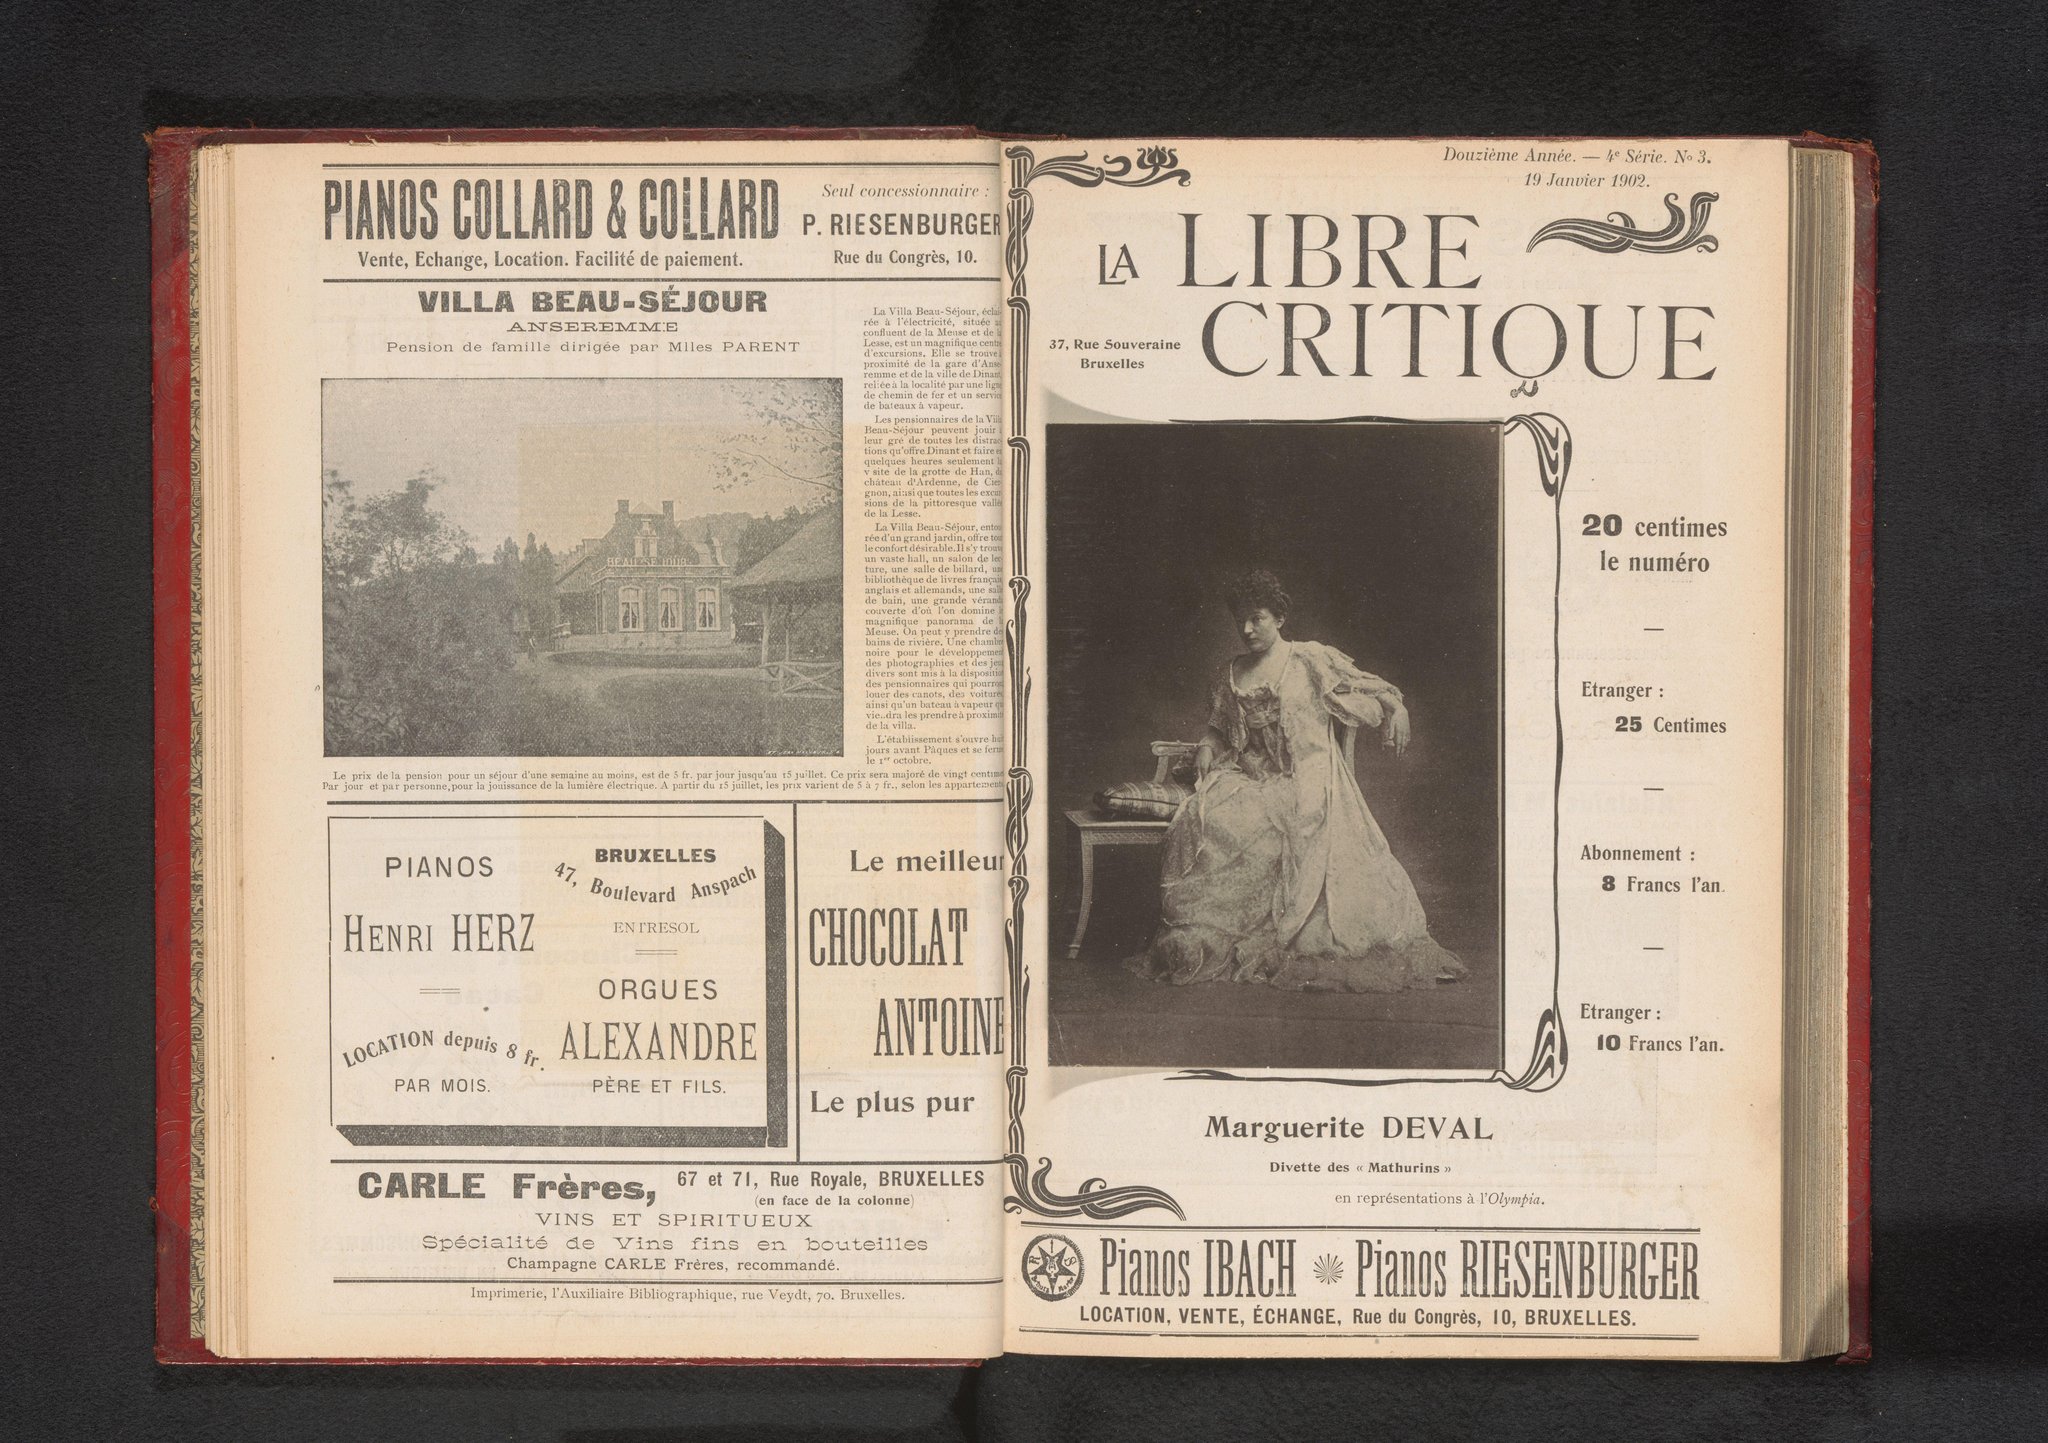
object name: photomechanical print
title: Portret van Marguerite Deval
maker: Anonymous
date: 1897-1902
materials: paper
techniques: photograph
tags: female singer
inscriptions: inscription: ‘Divette des < Mathurins > en représentations à l Ólympia.’